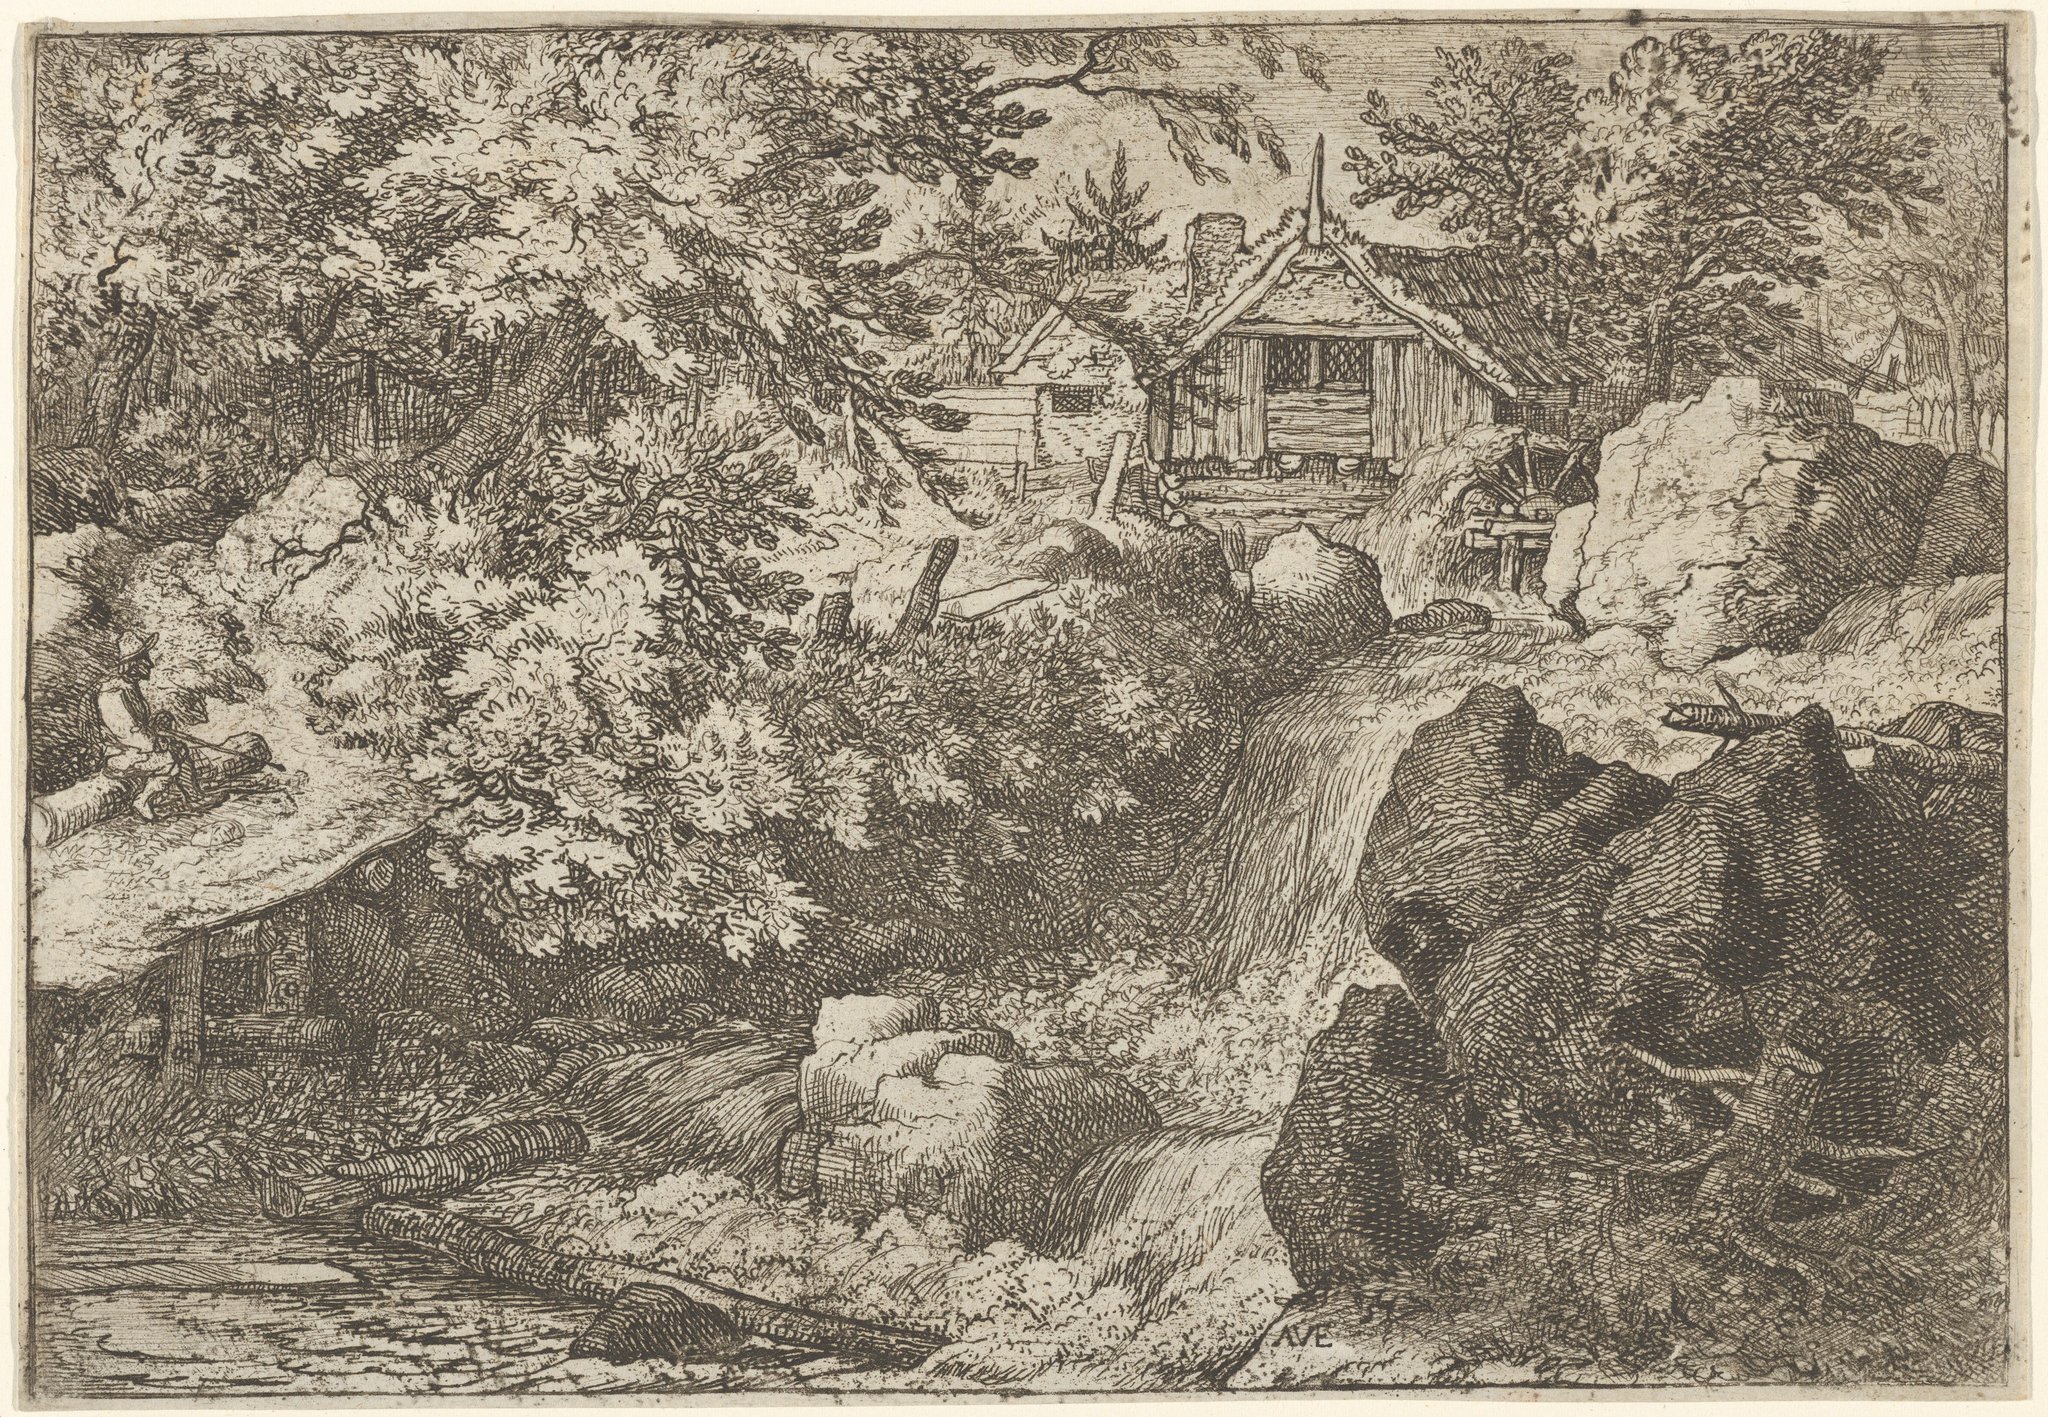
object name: print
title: The Cascade Near the Watermill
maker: allart van everdingen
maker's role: artist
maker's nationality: dutch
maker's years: 1621-1675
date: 1621-1675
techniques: engraving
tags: watermills,waterfalls,trees